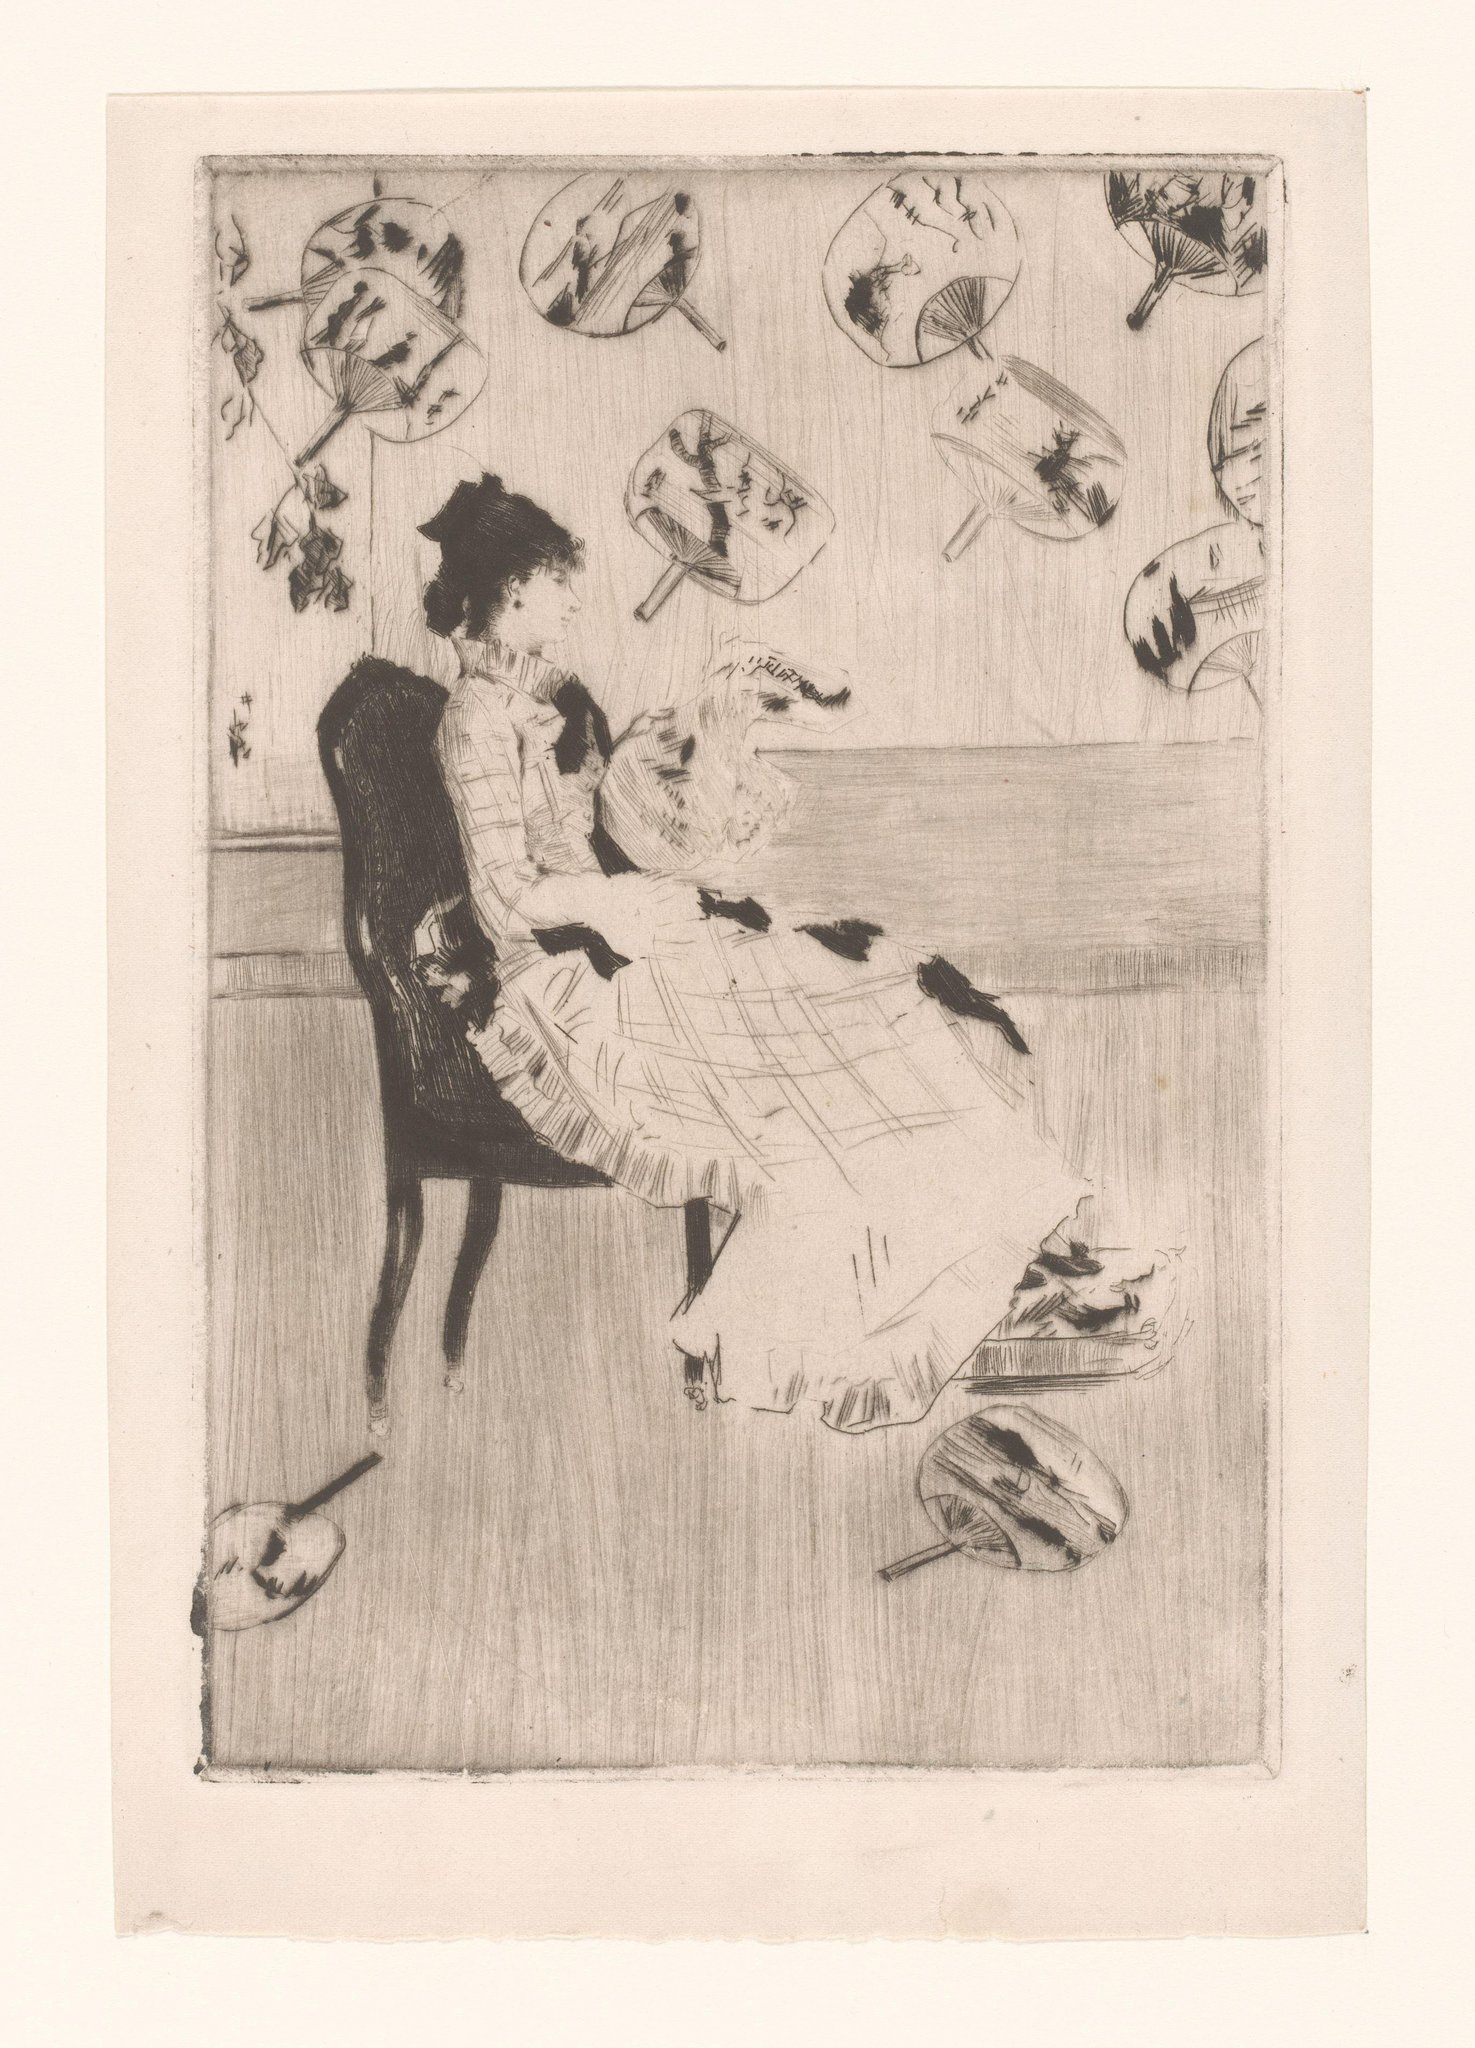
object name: print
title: Zittende vrouw, omringd door Japanse waaiers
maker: norbert goeneutte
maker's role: draughtsman, painter, print maker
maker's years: 1854-1894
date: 1880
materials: paper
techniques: drypoint, intaglio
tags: sitting figure - aa - female human figure, fan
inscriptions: collector's mark: Lugt 2760, collector's mark: Lugt 2228